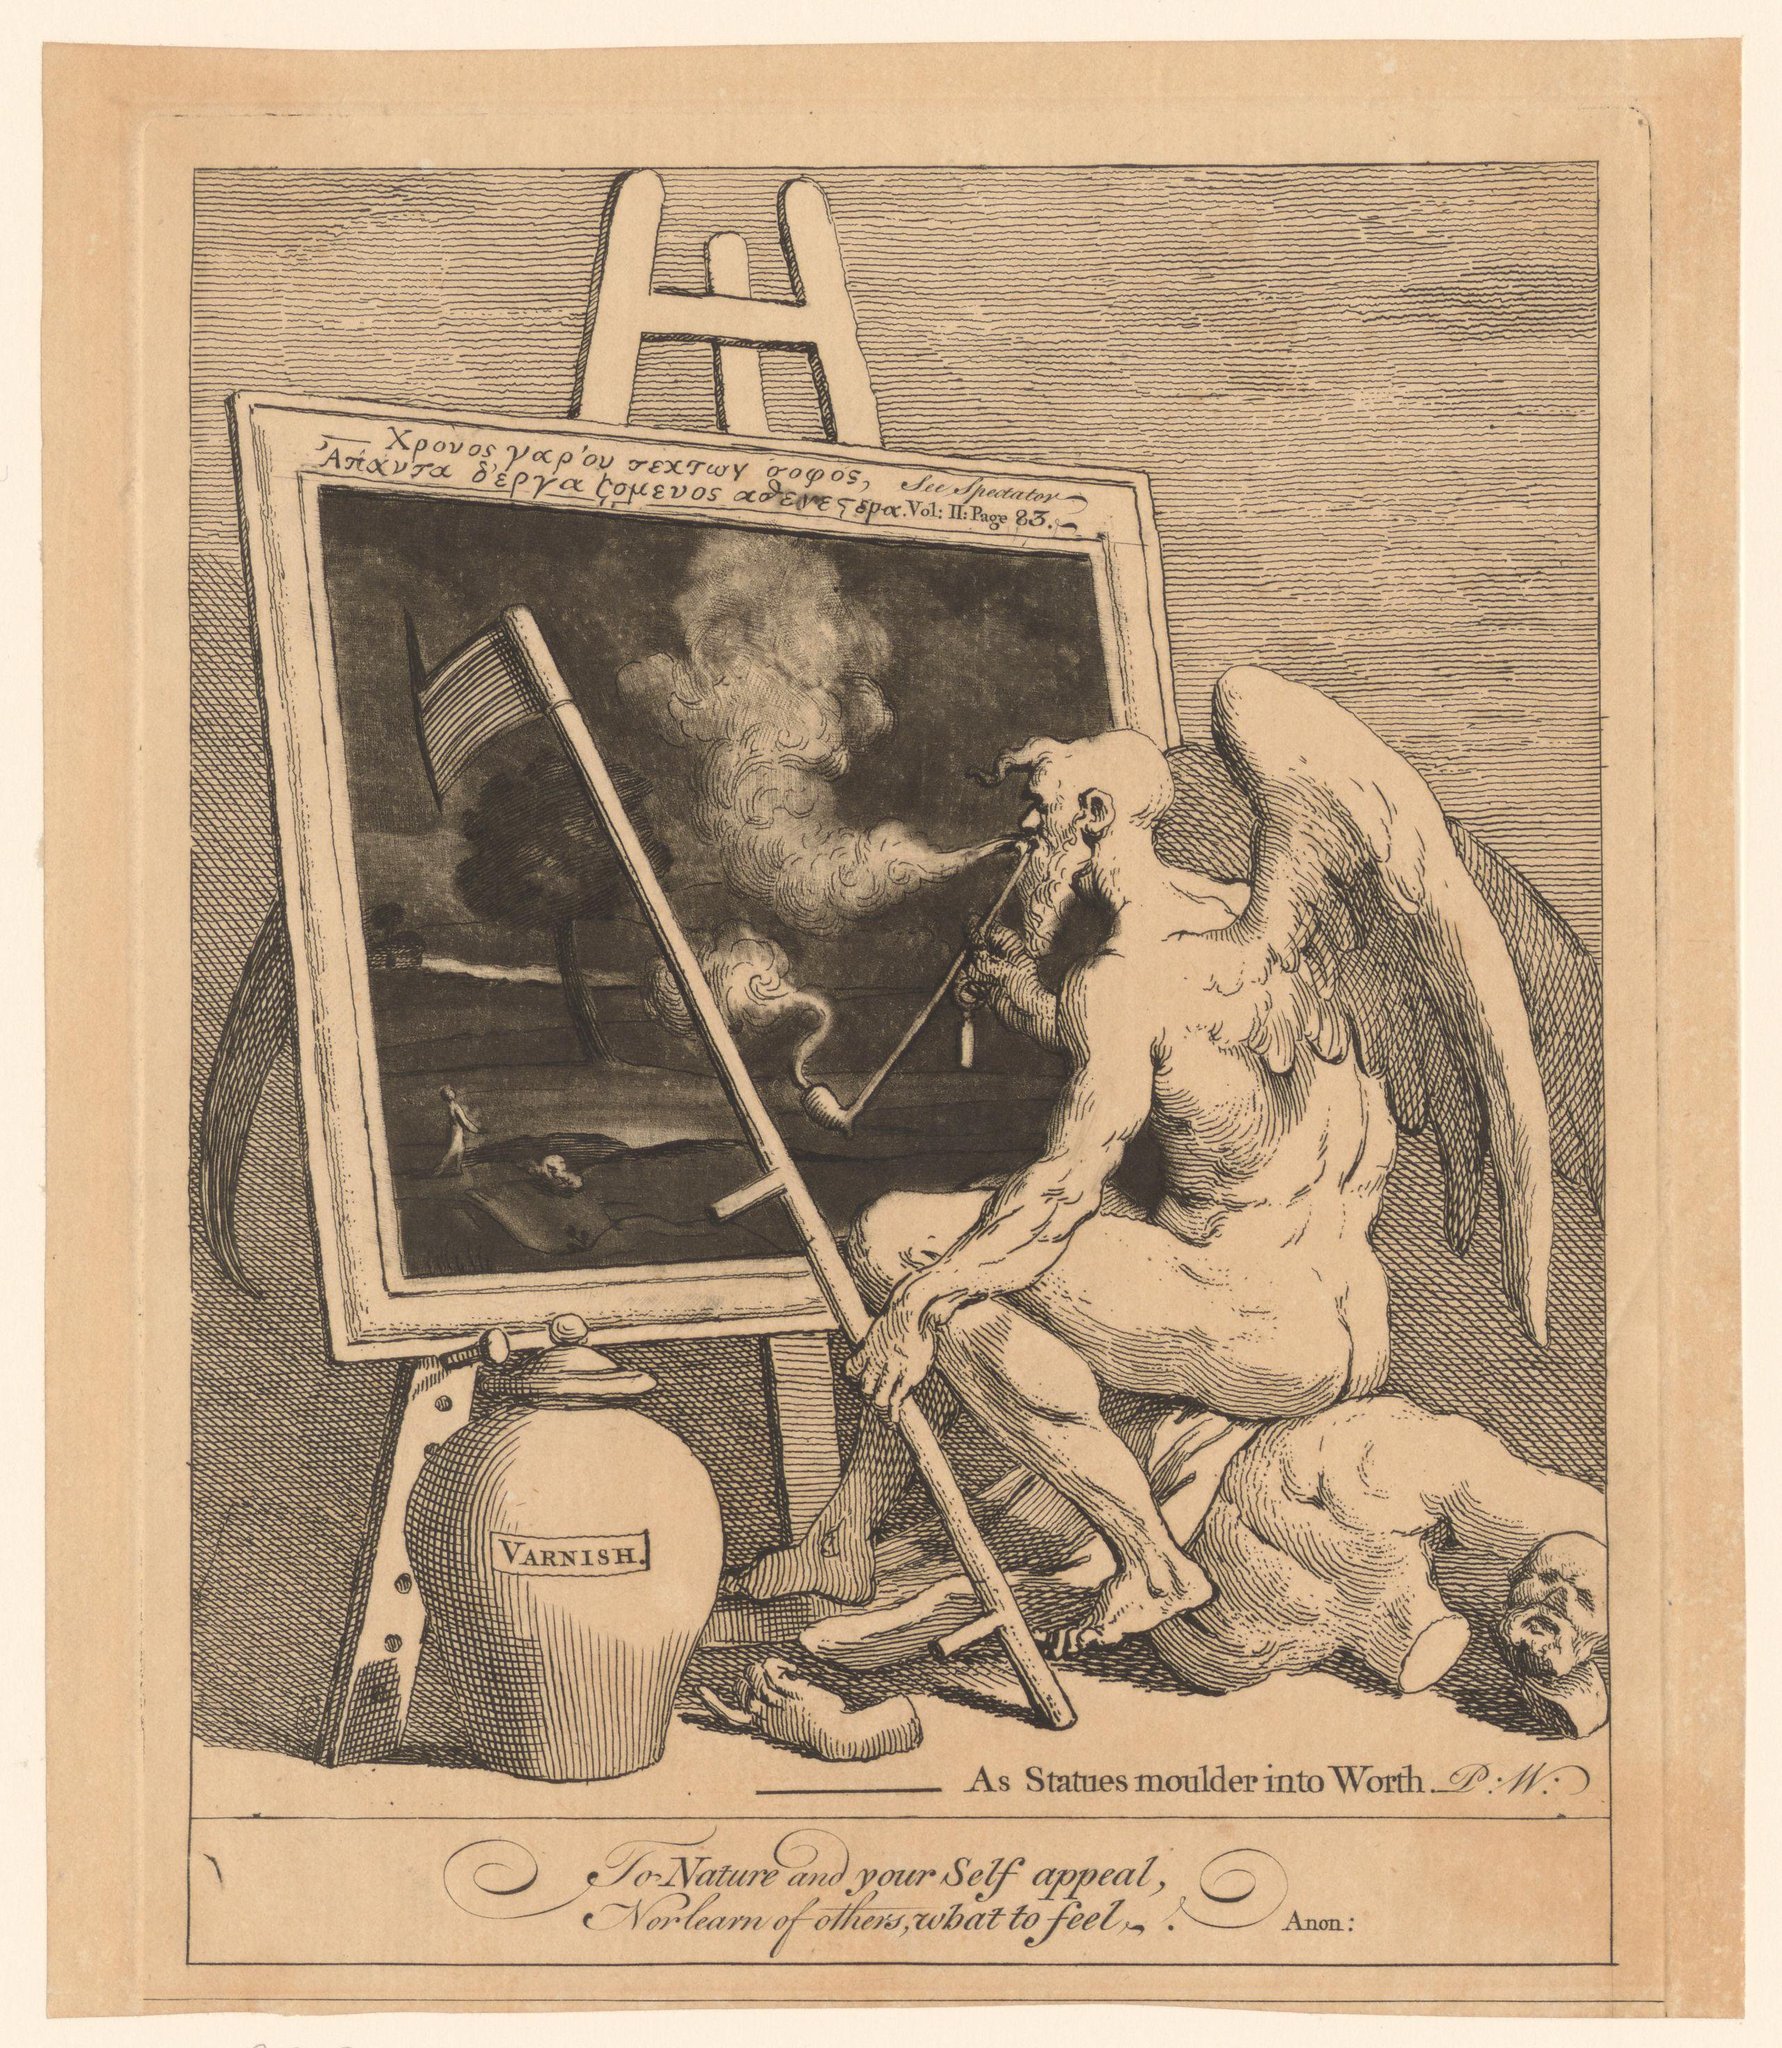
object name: print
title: Time Smoking a Picture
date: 1761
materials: paper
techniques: etching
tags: the arts; artists, father time, man with wings and scythe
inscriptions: collector's mark: Lugt 2228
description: De prent is waarschijnlijk oorspronkelijk bedoeld als aankoopbewijs (subscription ticket) voor prenten van het schilderij 'Sigismunda' door Hogarth. Hogarth impliceert met deze prent dat tijd en ouderdom kunst niet mooier maken maar juist verslechteren en reageert daarmee op Edmund Burke's essay over schoonheid (A Philosophical Enquiry into the Origin of Our Ideas of the Sublime and Beautiful, 1757). De Griekse tekst op de lijst komt van Krates van Thebe en betekent grofweg: 'tijd is geen groot kunstenaar, expert of vakman, het verzwakt juist alles wat het aanraakt'.